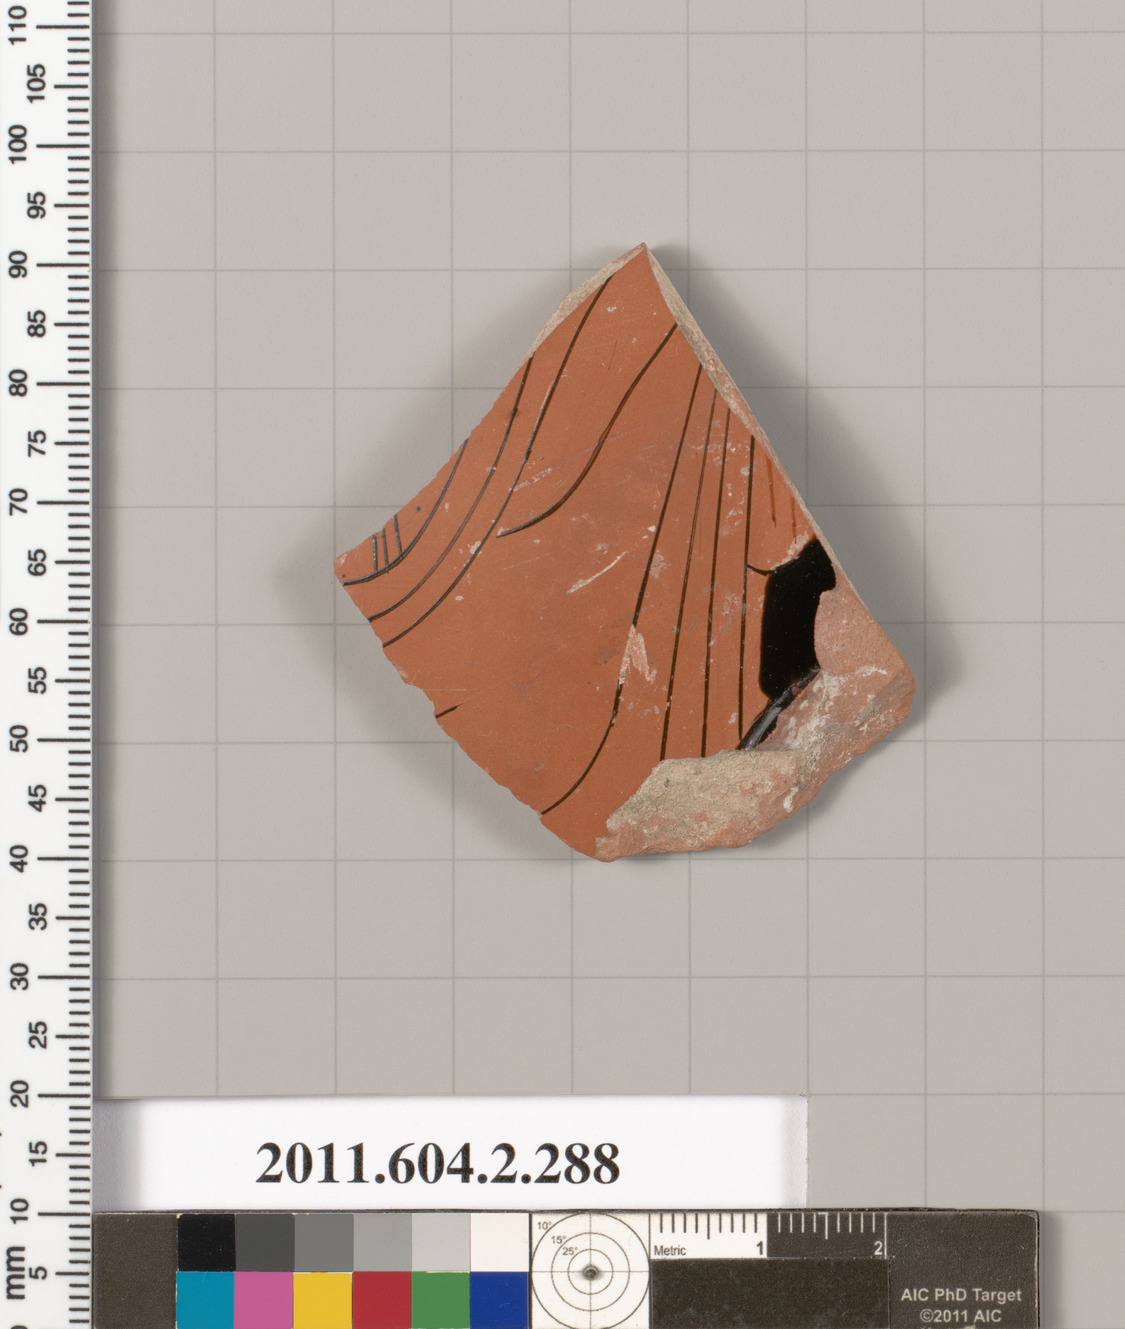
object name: column krater fragment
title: Terracotta fragment of a column-krater? (bowl for mixing wine and water)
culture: greek, attic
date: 460-440 BCE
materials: terracotta